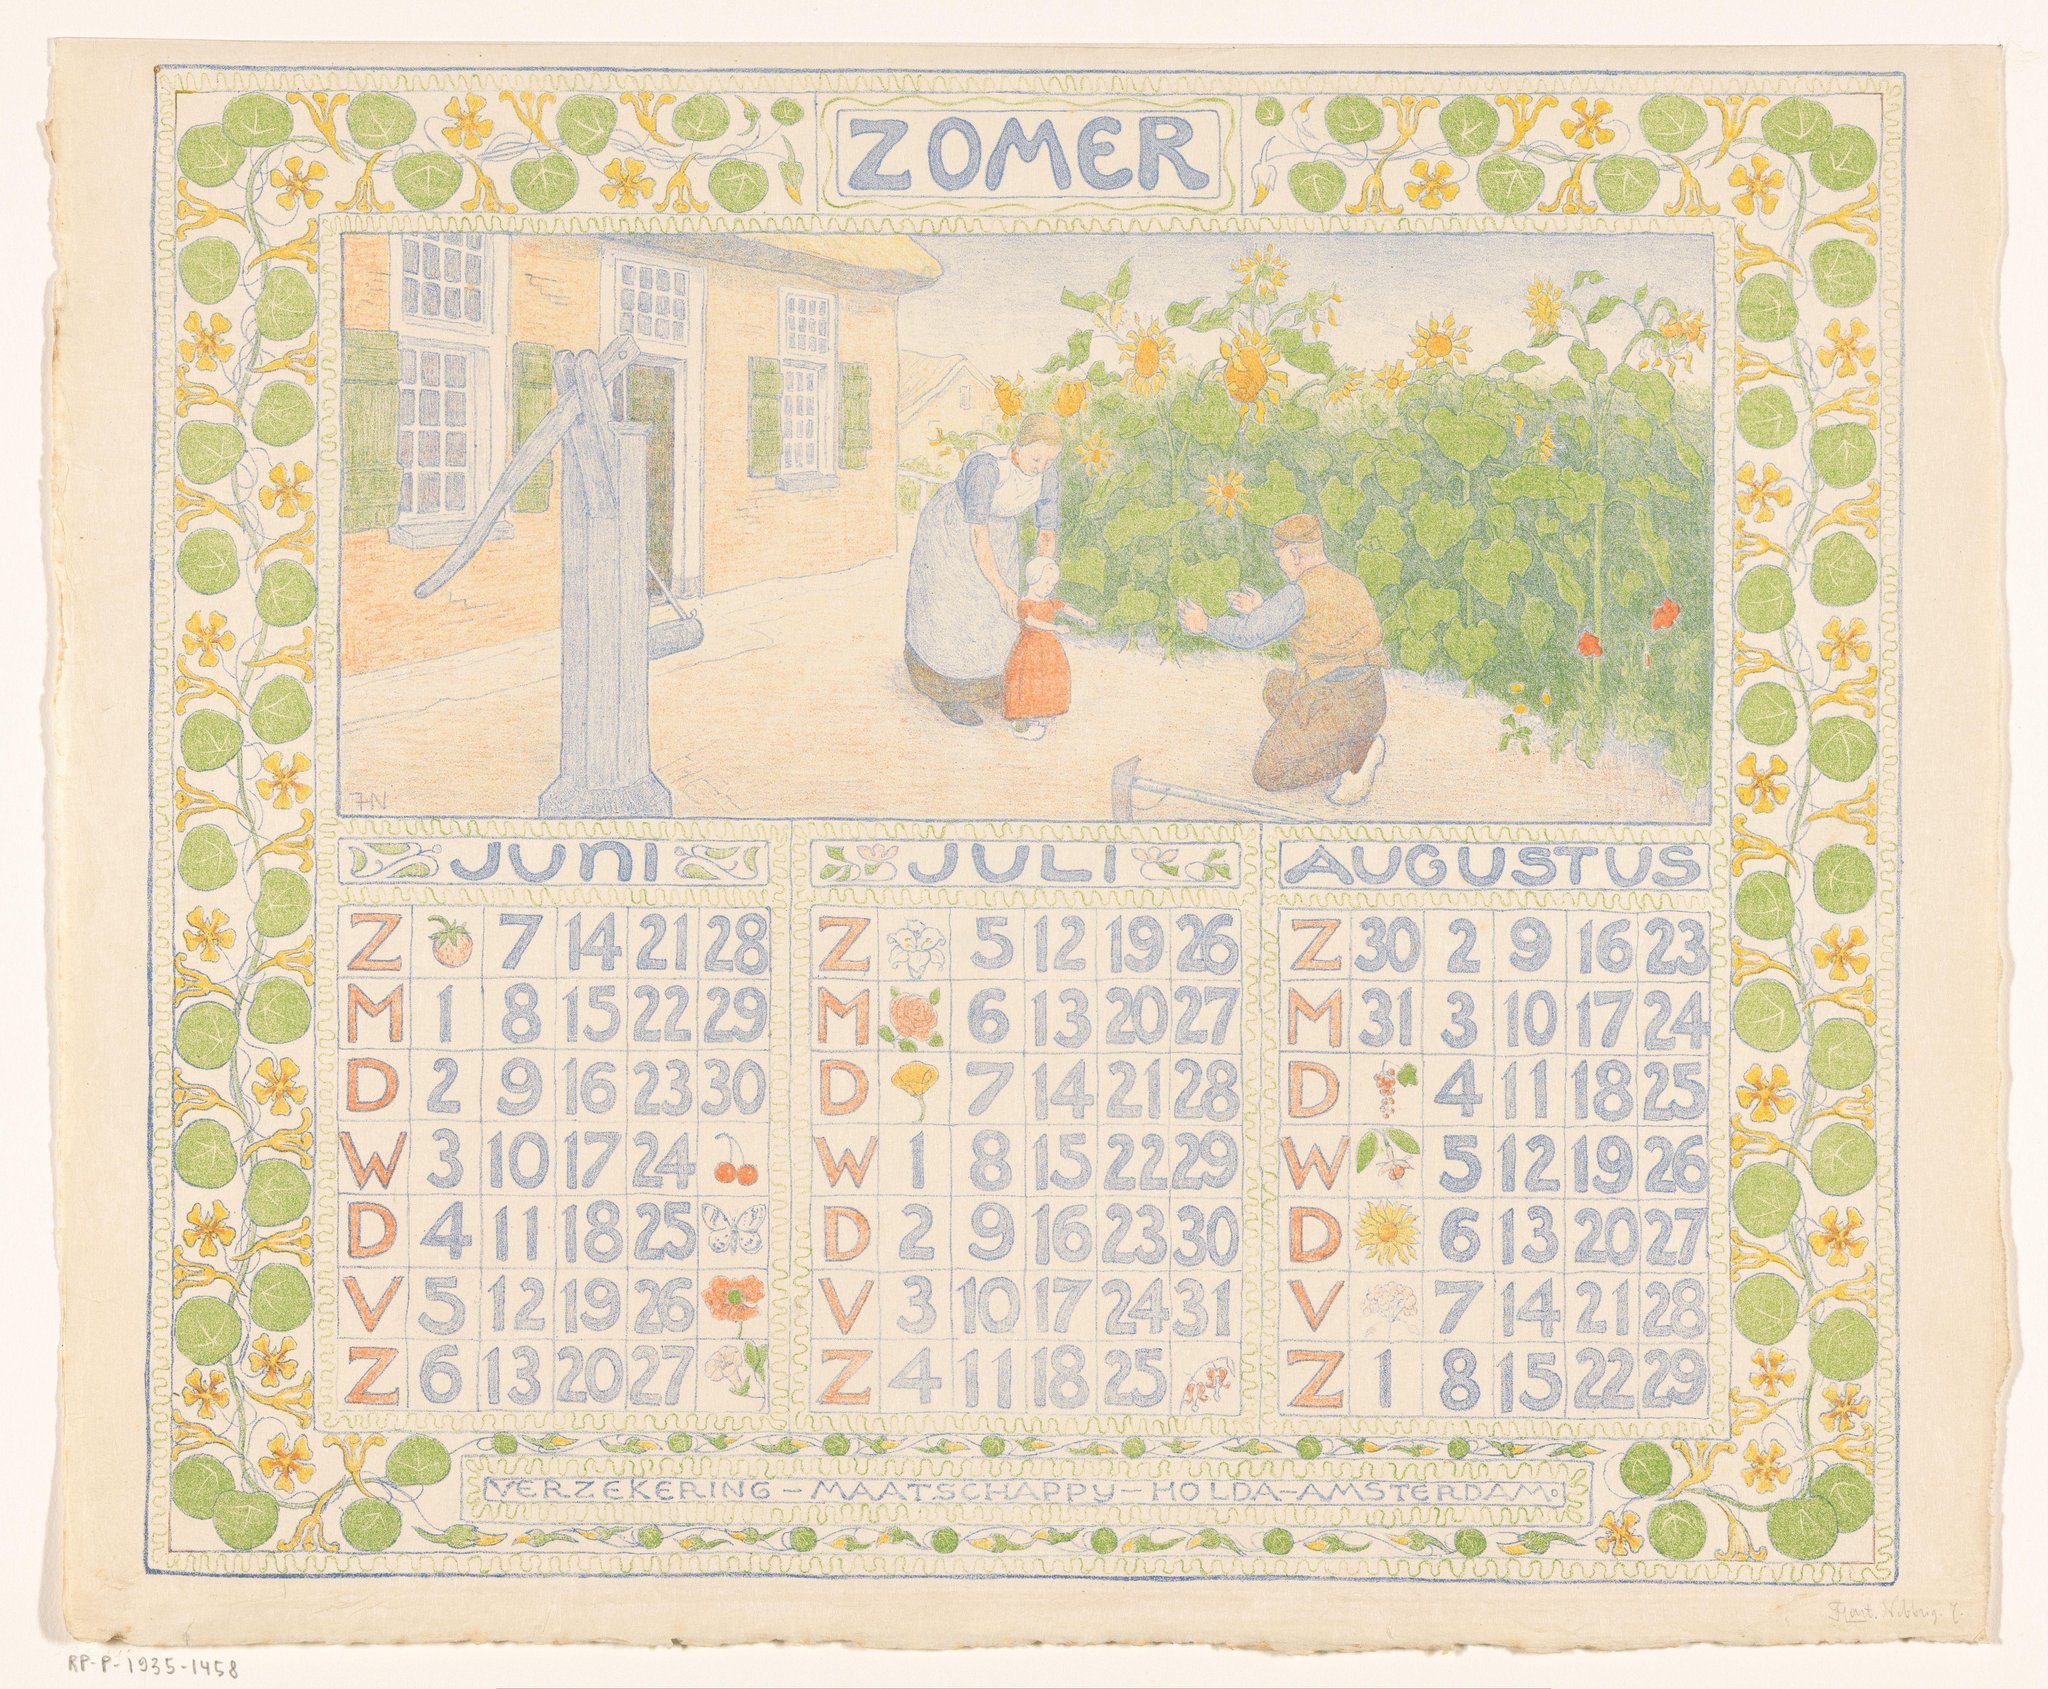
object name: calendar leaf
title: Kalenderblad voor zomer 1904 van de Verzekering-Maatschappij Holda in Amsterdam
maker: ferdinand hart nibbrig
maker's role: draughtsman, painter, print maker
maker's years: 1866-1915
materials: paper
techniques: lithograph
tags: flowers: sunflower, summer ~ human activities (the four seasons of the year), pump, farm (building)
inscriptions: collector's mark: Lugt 2760, collector's mark: Lugt 2165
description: Een rechthoekig kader opgevuld met de dagen van de maanden juni, juli en augustus en daarboven een man en een vrouw die een meisje leren lopen. Links een waterpomp bij een boerderij. Rechts zonnebloemen.